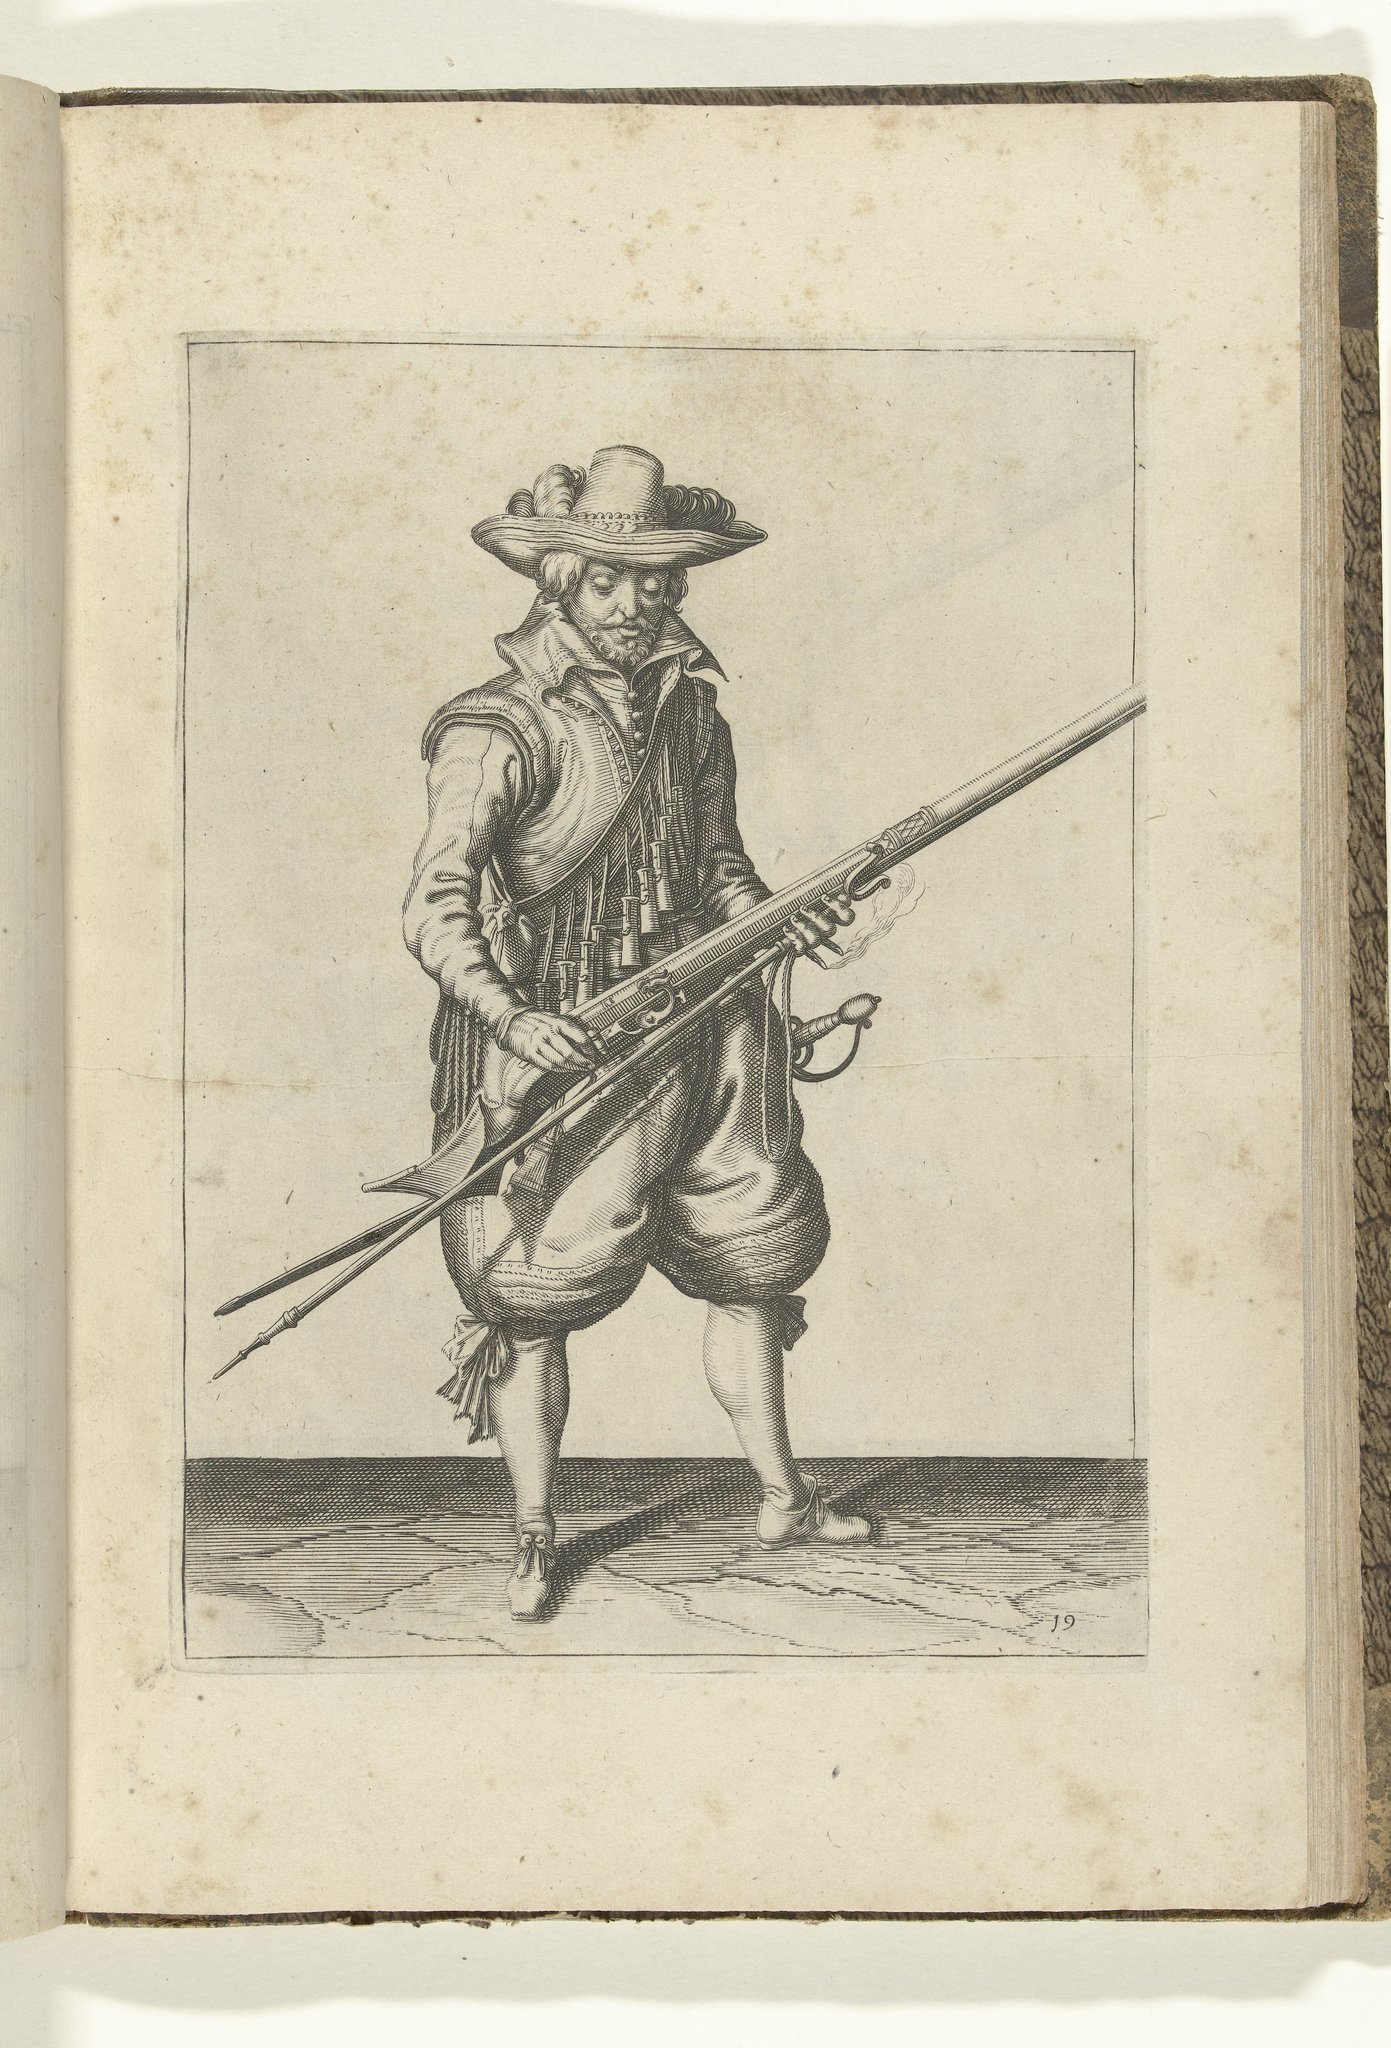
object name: print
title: Soldaat die kruit van zijn musket schudt (nr. 19), ca. 1600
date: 1597-1608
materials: paper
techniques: engraving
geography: amsterdam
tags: maurice (prince of orange), handling of weapons ~ military training, weapons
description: Een soldaat, ten voeten uit, naar rechts, die met beide handen een musket (een bepaald type vuurwapen) schudt, om eventueel buiten de pan (het kruitreservoir) gevallen kruit ervan af te krijgen (nr. 19), ca. 1600. In zijn linkerhand behalve de loop van het musket ook een furket (musketvork) en een brandende lont. Plaat 19 in de instructies voor het hanteren van het musket: Brief enseignement, sur les pourtraitz figurez, touchant le droit maniement du Mousquet. Onderdeel van de illustraties in een Franse editie van J. de Gheyns Wapenhandelinghe: J. de Gheyn, Maniement d'armes, d'arquebuses, mousquetz et piques : en conformité de l'ordre de Mour le Prince Maurice, Prince d'Orange, Amsterdam 1608. Krijgswezen rond 1600.